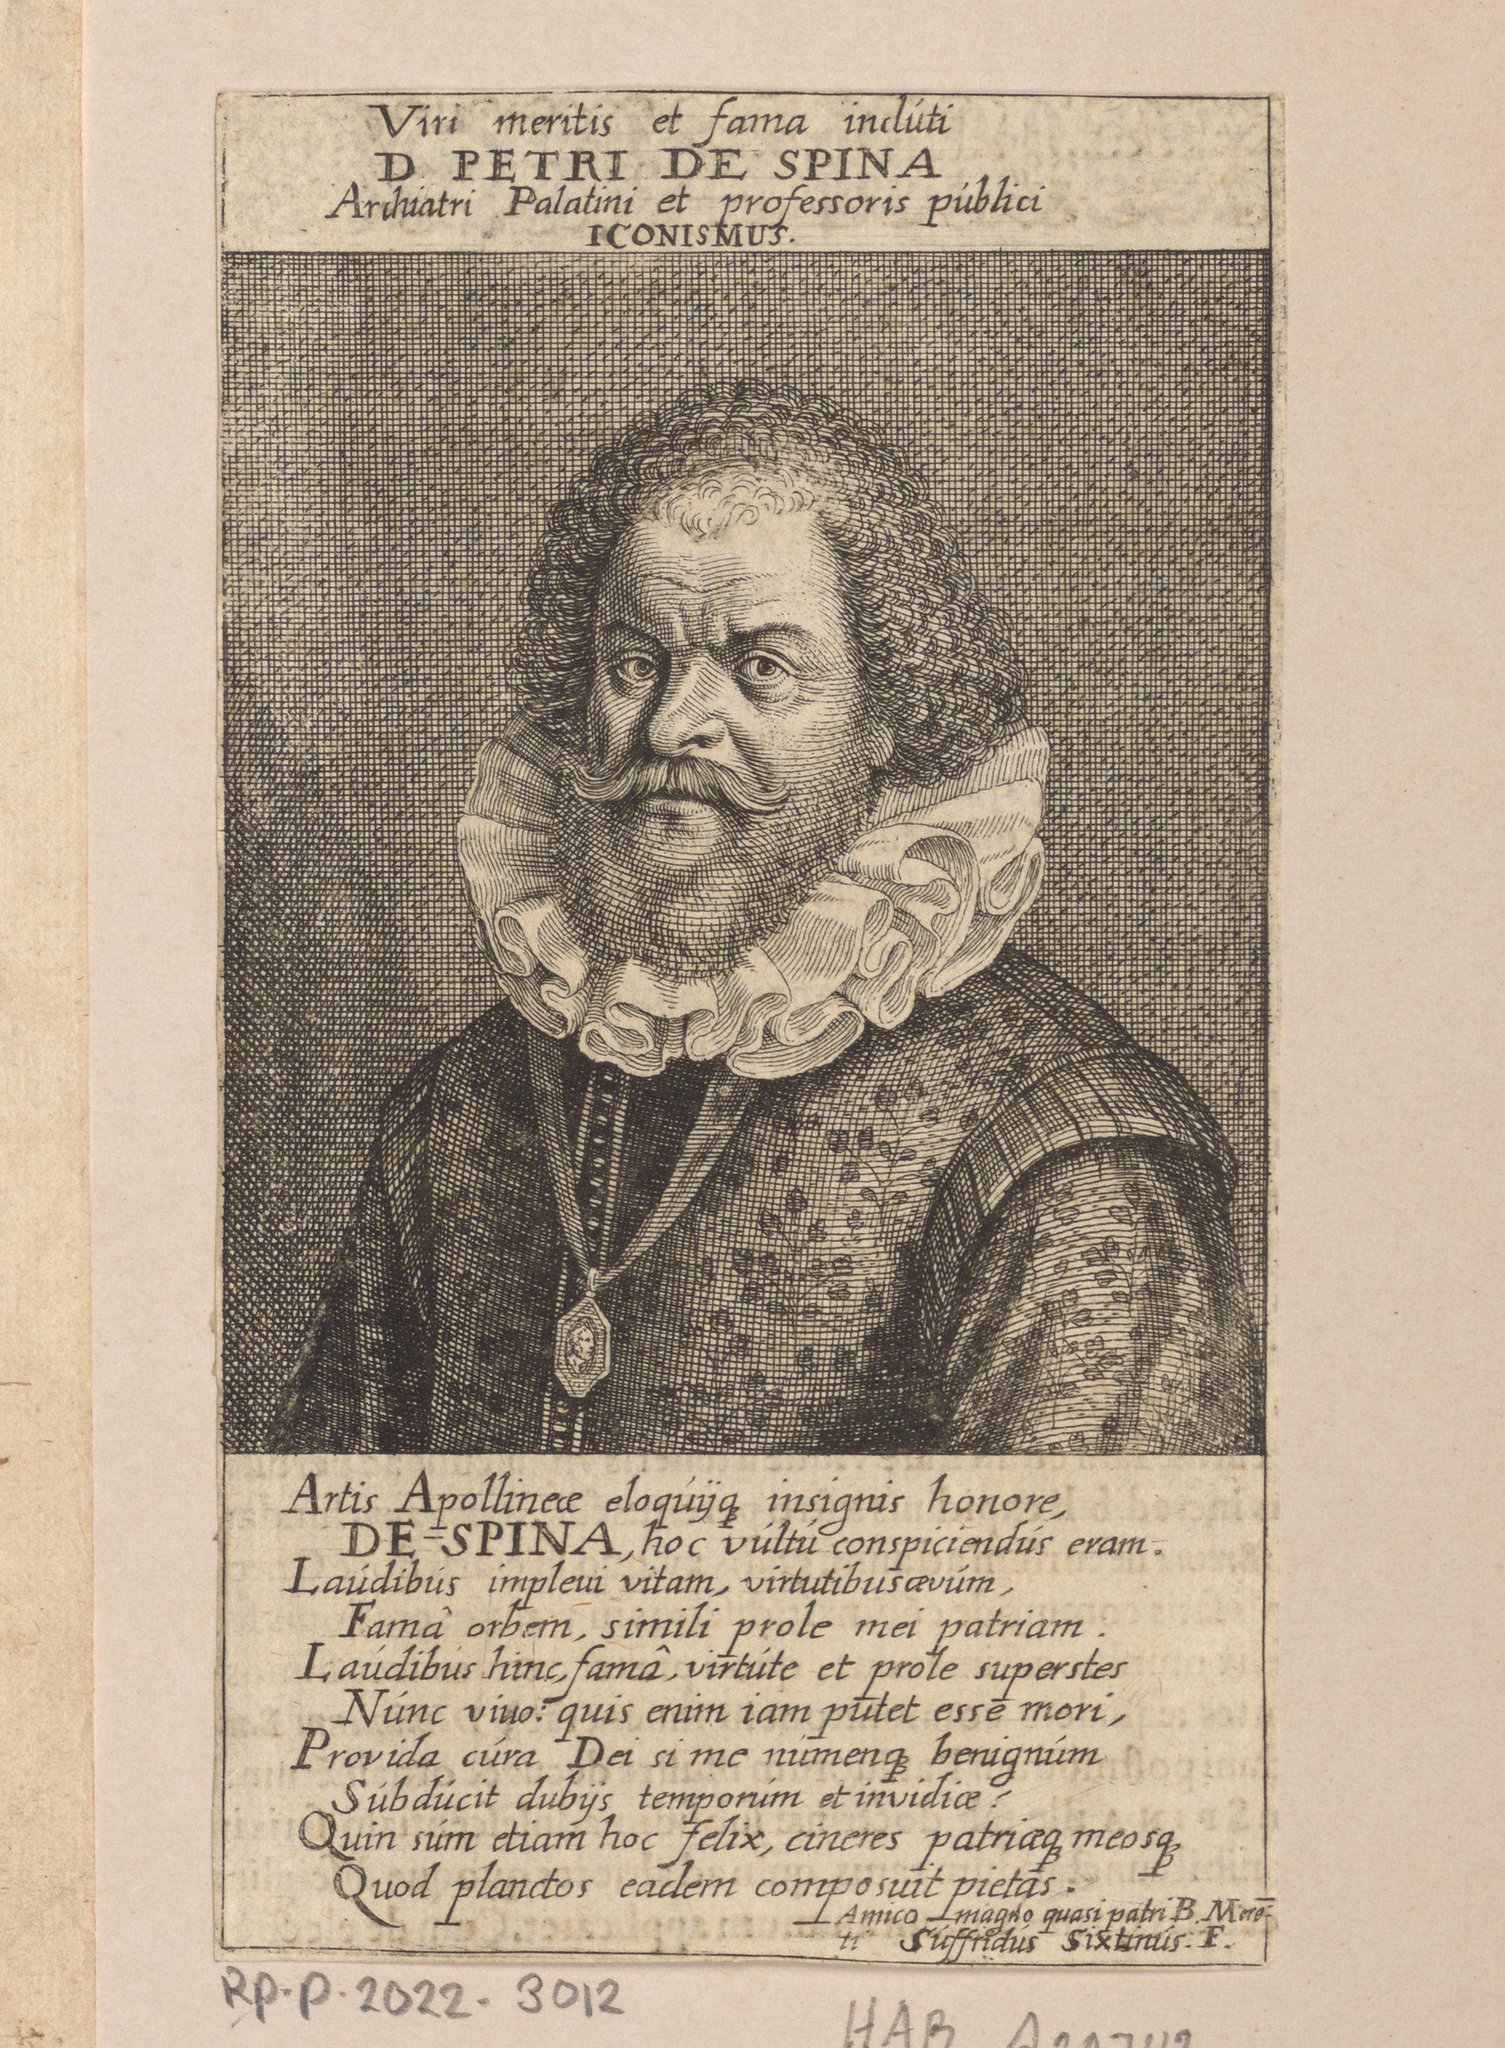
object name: book illustration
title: Portret van Peter Spina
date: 1630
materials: paper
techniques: engraving, etching, letterpress printing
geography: frankfurt am main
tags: historical persons, physician, doctor (+ portrait of scholar, scientist)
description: Prent uit: Boissard, Jean-Jacques. Bibliotheca sive thesaurus virtutis et gloriae in quo continentur illustrium eruditione et doctrina virorum effigies et vitae (...). Frankfurt: William Fitzer, 1630.